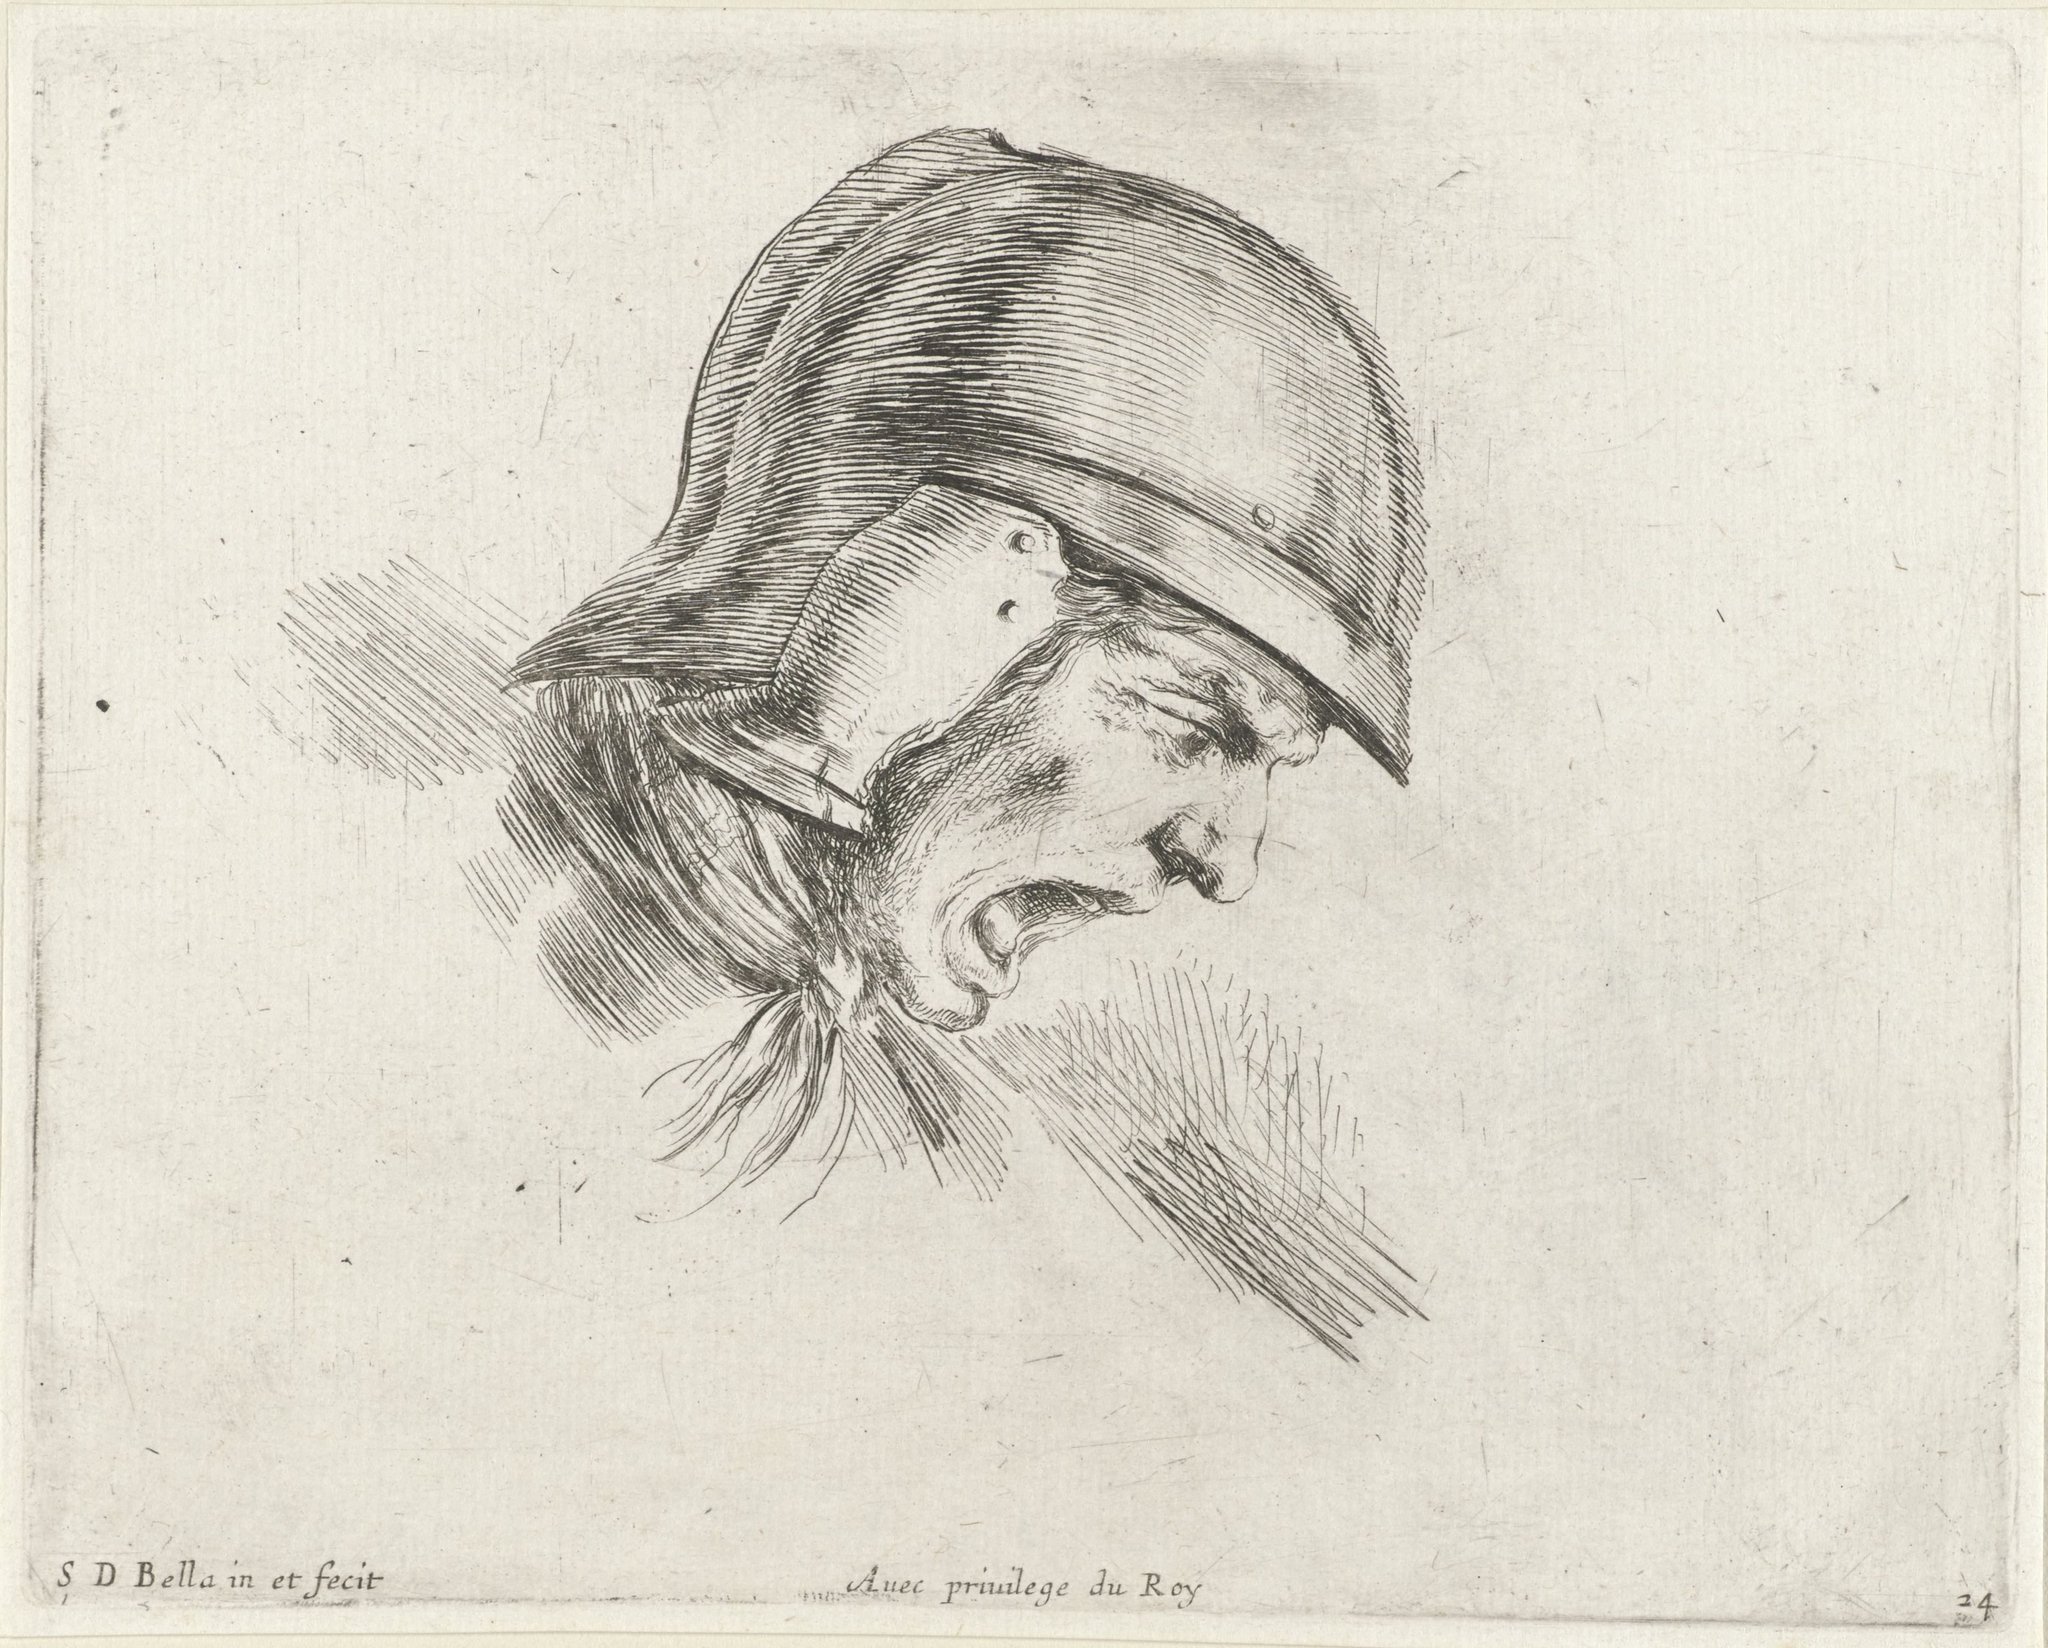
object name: print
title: Hoofd van een schreeuwende soldaat, naar rechts beneden gewend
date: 1620-1664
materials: paper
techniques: etching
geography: paris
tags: helmet, head (human) (+ sideview, profile), the soldier; the soldier's life, crying, shouting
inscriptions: collector's mark: Lugt 240